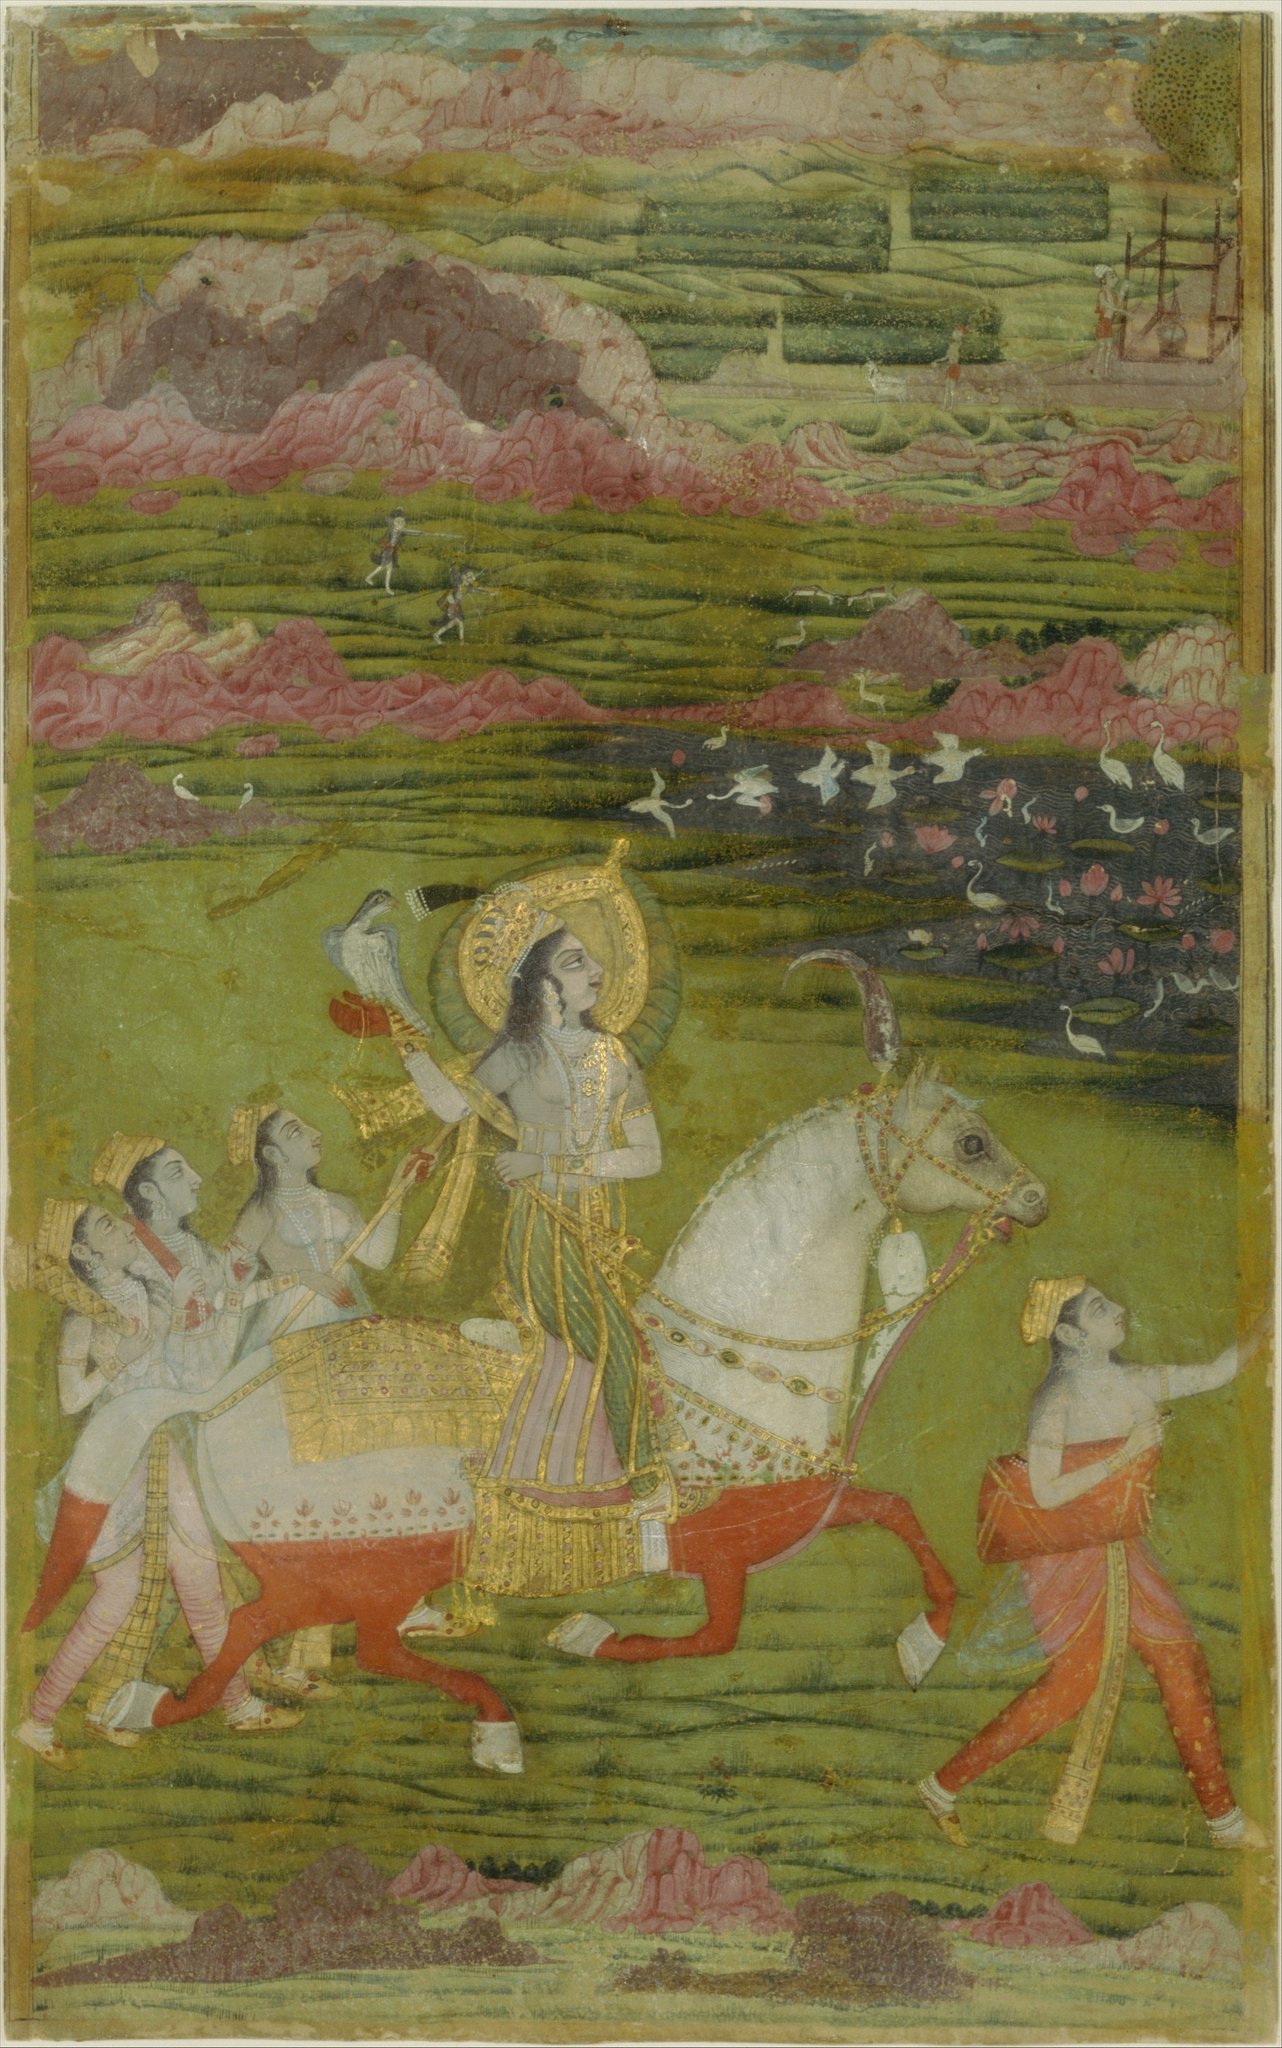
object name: illustrated single work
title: Chand Bibi Hawking with Attendants in a Landscape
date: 1700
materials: gold, paper, silver, watercolor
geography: india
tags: birds,hawks,queens,men,women,horses,landscapes